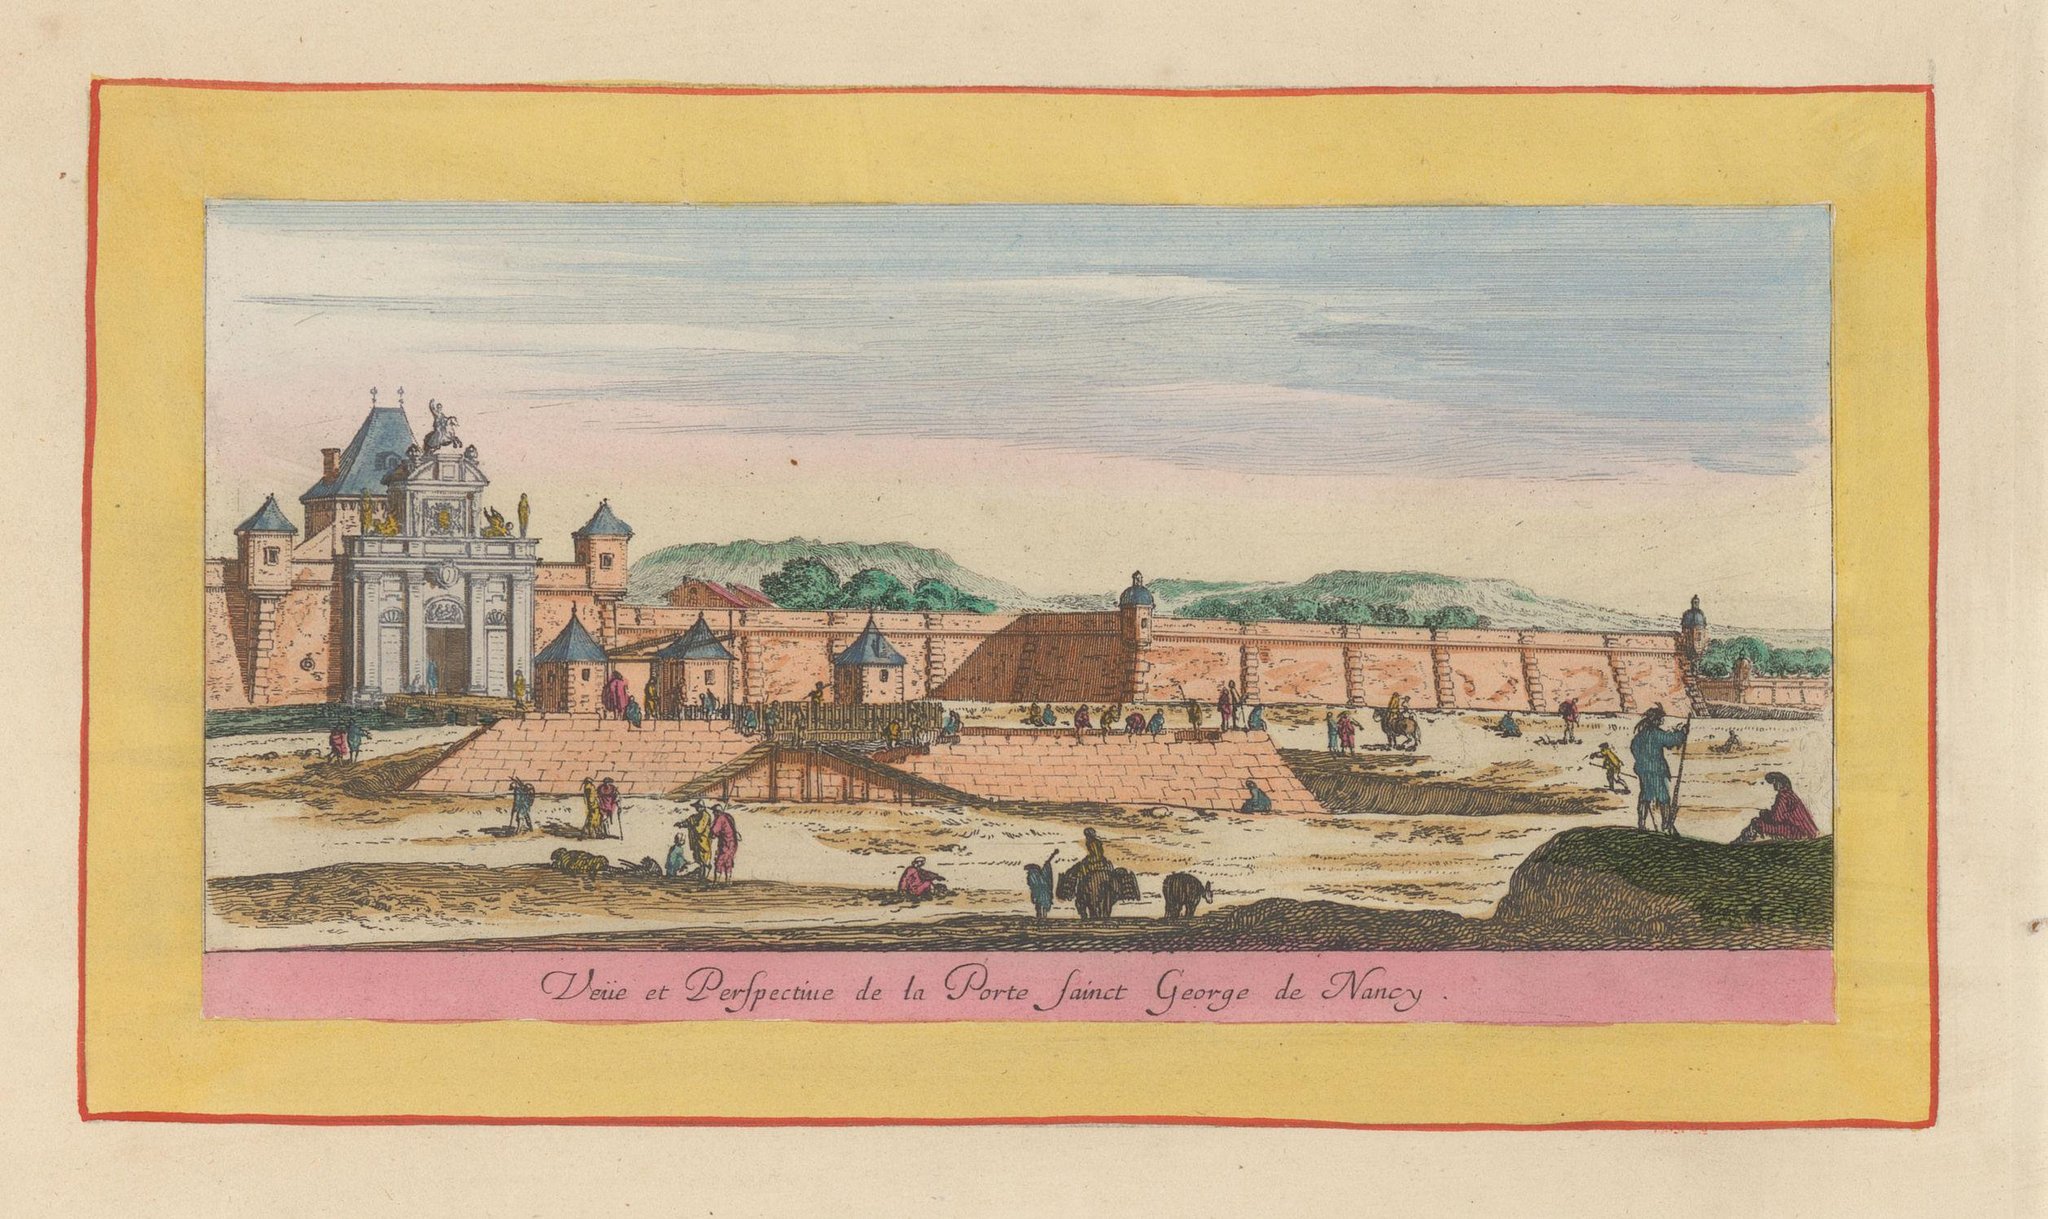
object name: album leaf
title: Profil de la ville de Nancy, auquel sont jointes les veuës et perspectives des portes et lieux plus remarquables des environs d'icelle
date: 1631-1661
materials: paper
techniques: etching, hand coloring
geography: paris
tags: city-view in general; 'veduta', city-gate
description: Deze prent maakt deel uit van een album.